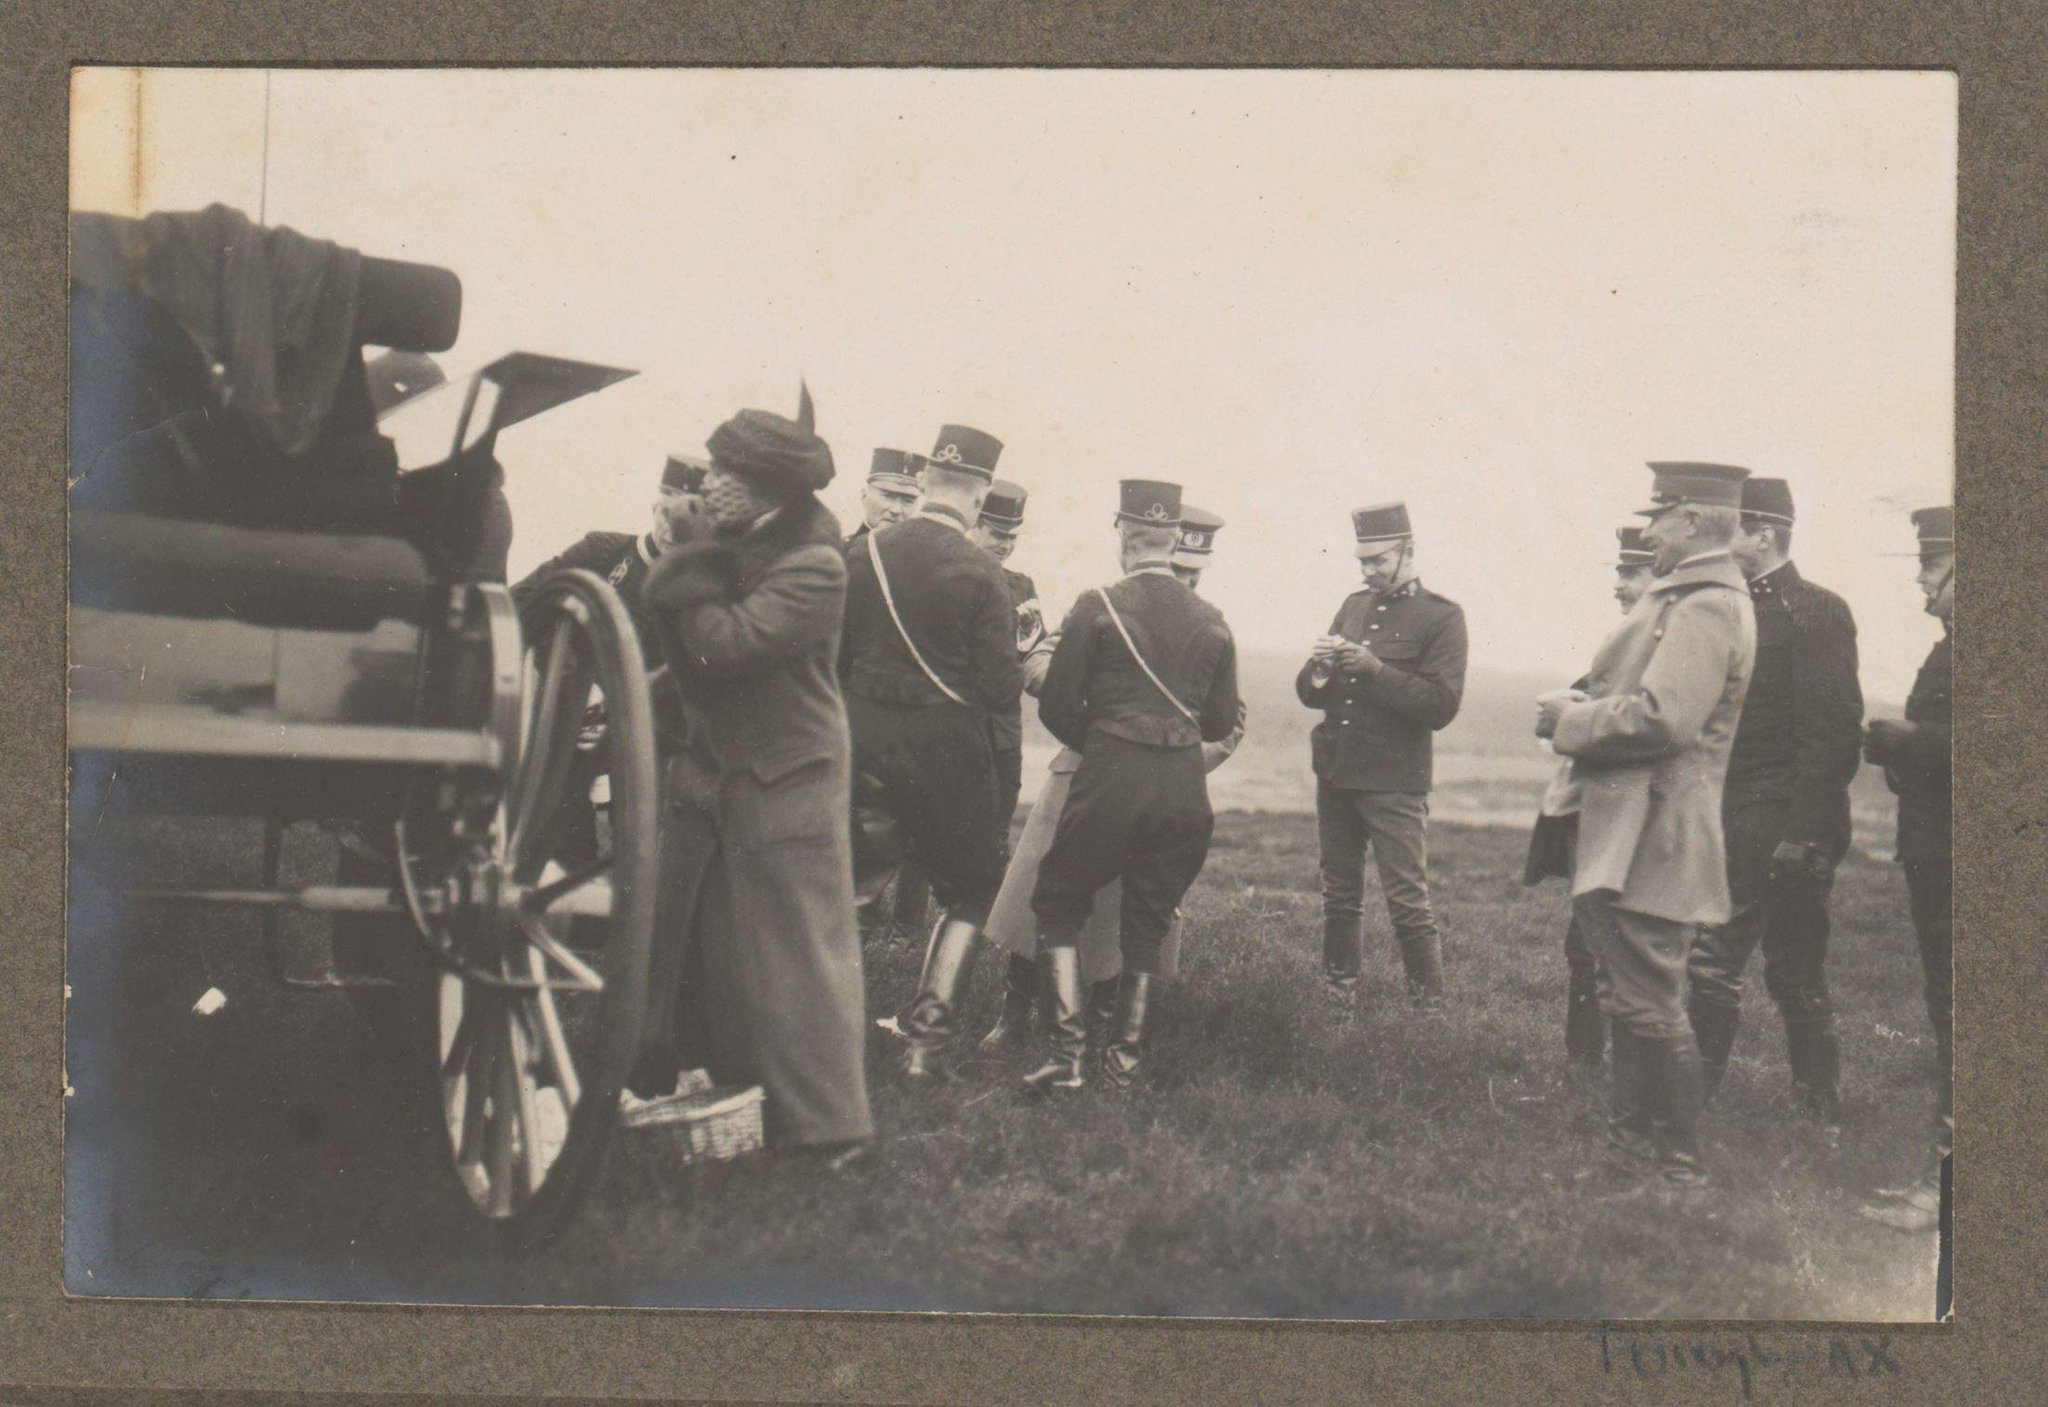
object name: photograph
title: Ruitertafereel op Koninklijke Houtvesterij Het Loo: gezelschap bij een rijtuig in een veld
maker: Anonymous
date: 1900-1925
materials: photographic support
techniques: gelatin silver print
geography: het loo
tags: animal traction, animal-drawn vehicle (carriage etc.), hunting, chase, hunting-ground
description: Onderdeel van Fotoalbum van de heer Brams, opperhoutvester van koningin Wilhelmina op Koninklijke Houtvesterij Het Loo.